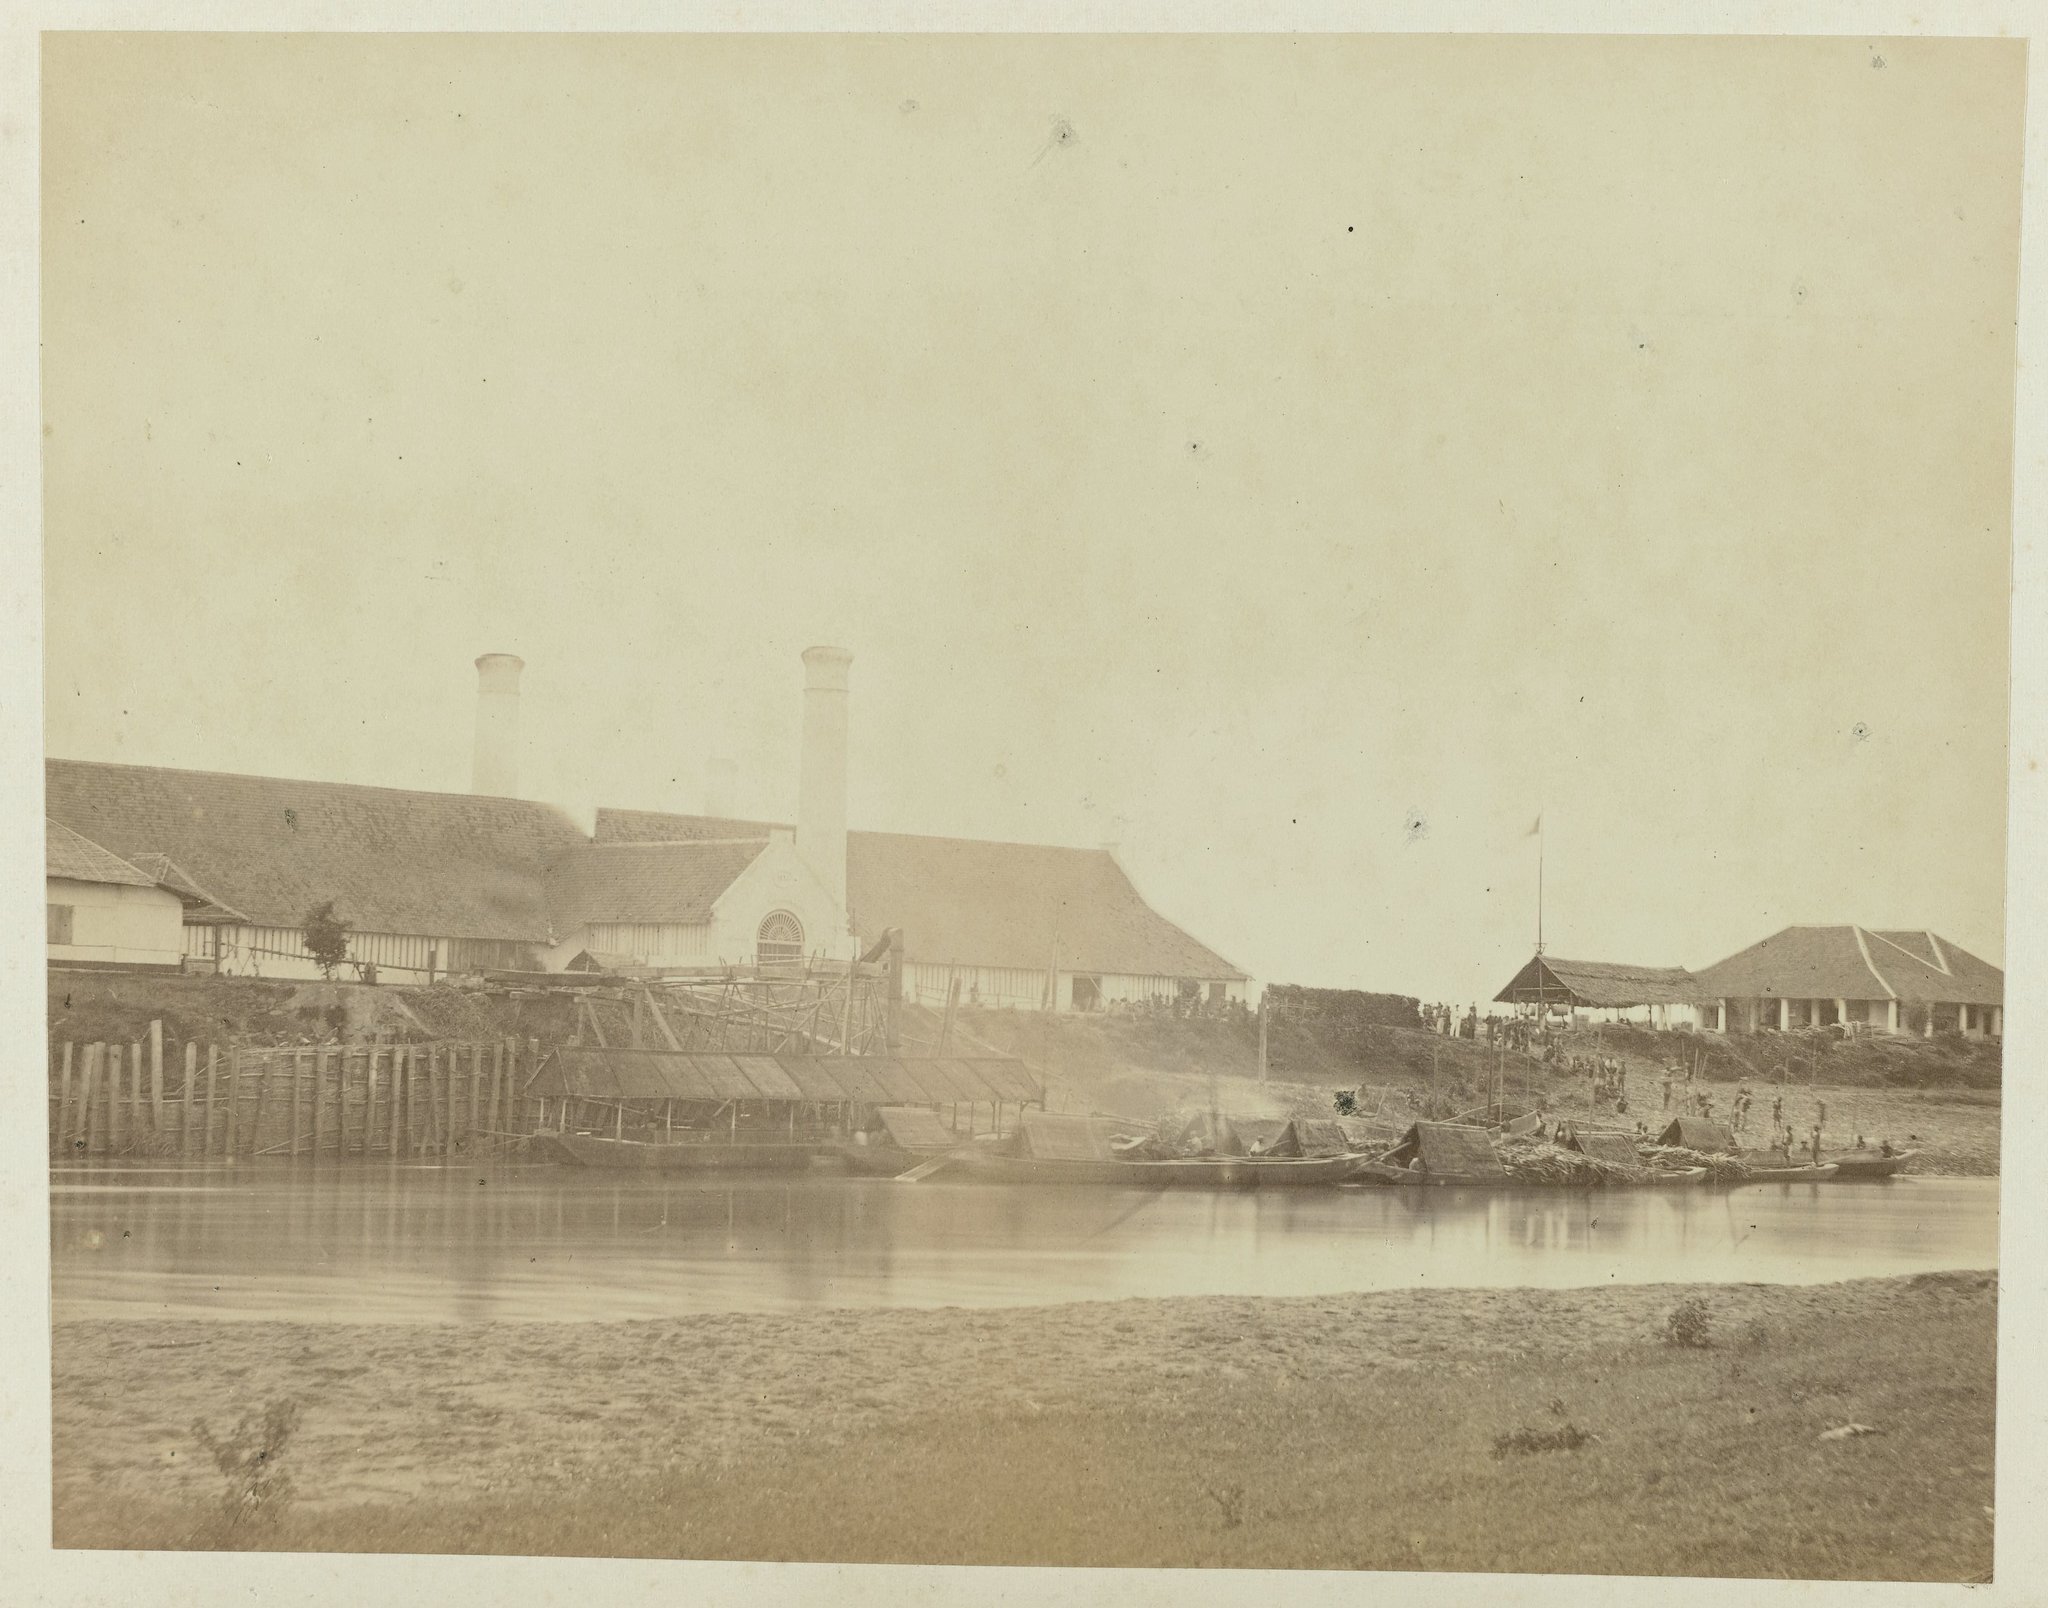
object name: photograph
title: Fabriek Soeka Sarie 1861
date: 1863-1869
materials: photographic support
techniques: albumen print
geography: java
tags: factory-building, java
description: Fabrieksgebouw met de naam Soeka Sarie en het jaartal 1861, gezien vanaf de overzijde van een rivier. Onderdeel van het groene fotoalbum met foto's van Java, uit het bezit van apotheker Specht-Grijp, die in 1865 vanuit Batavia naar Nederland terugkeerde.